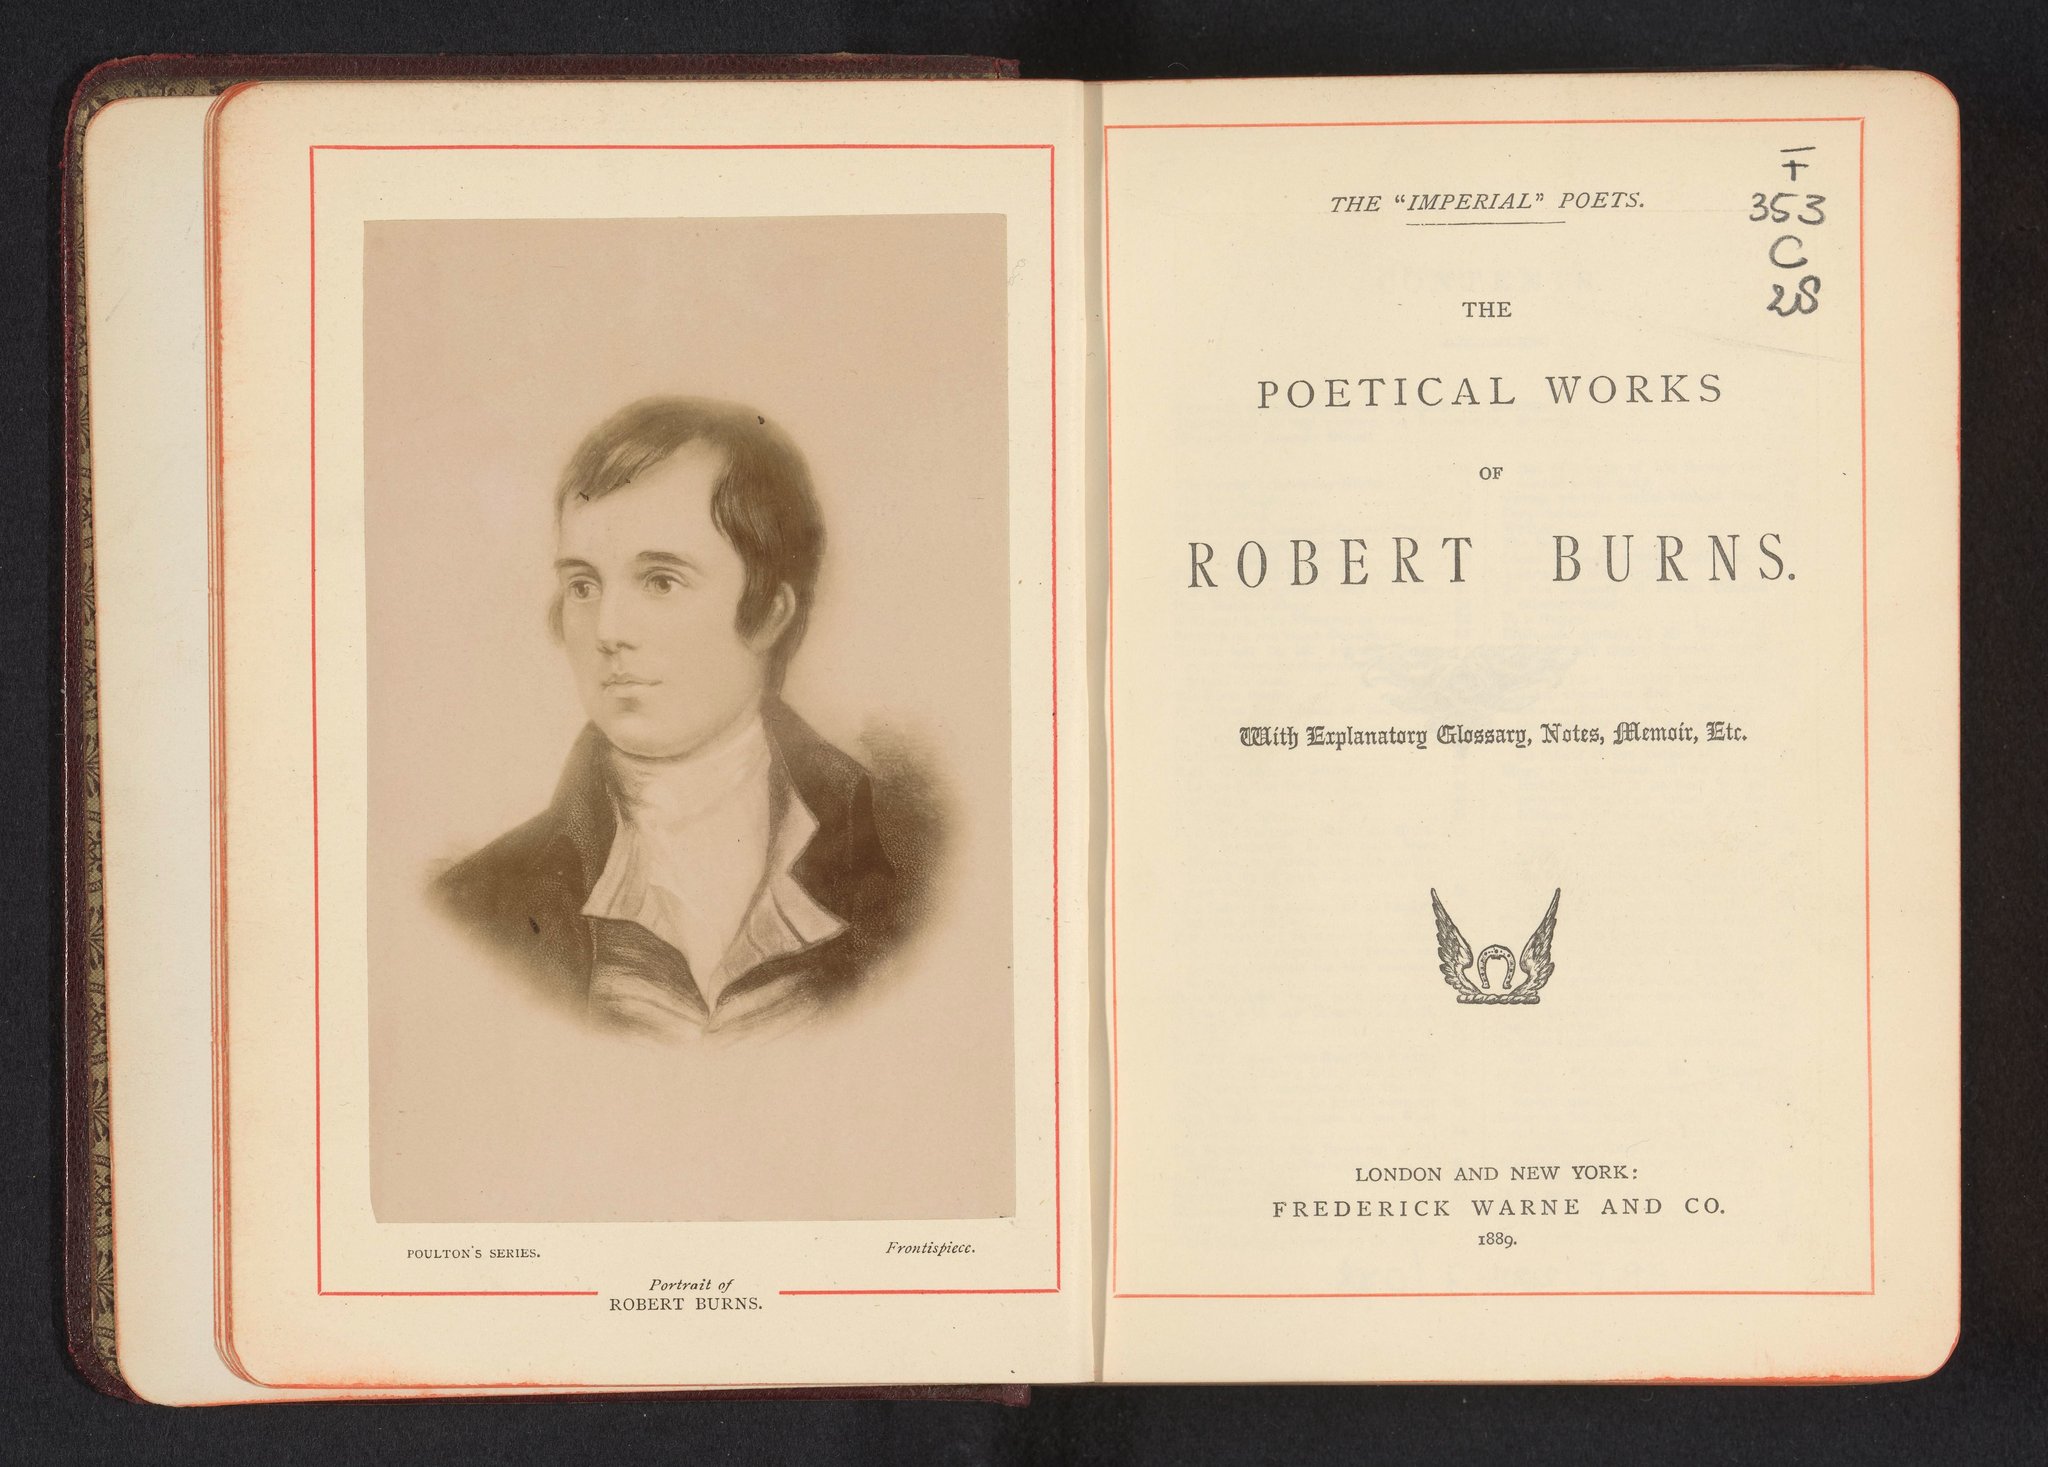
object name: photograph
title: Portrait of Robert Burns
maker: Anonymous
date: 1879-1889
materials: photographic support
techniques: albumen print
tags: robert burns, portrait of a writer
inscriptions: inscription: ‘Poulton's series.’